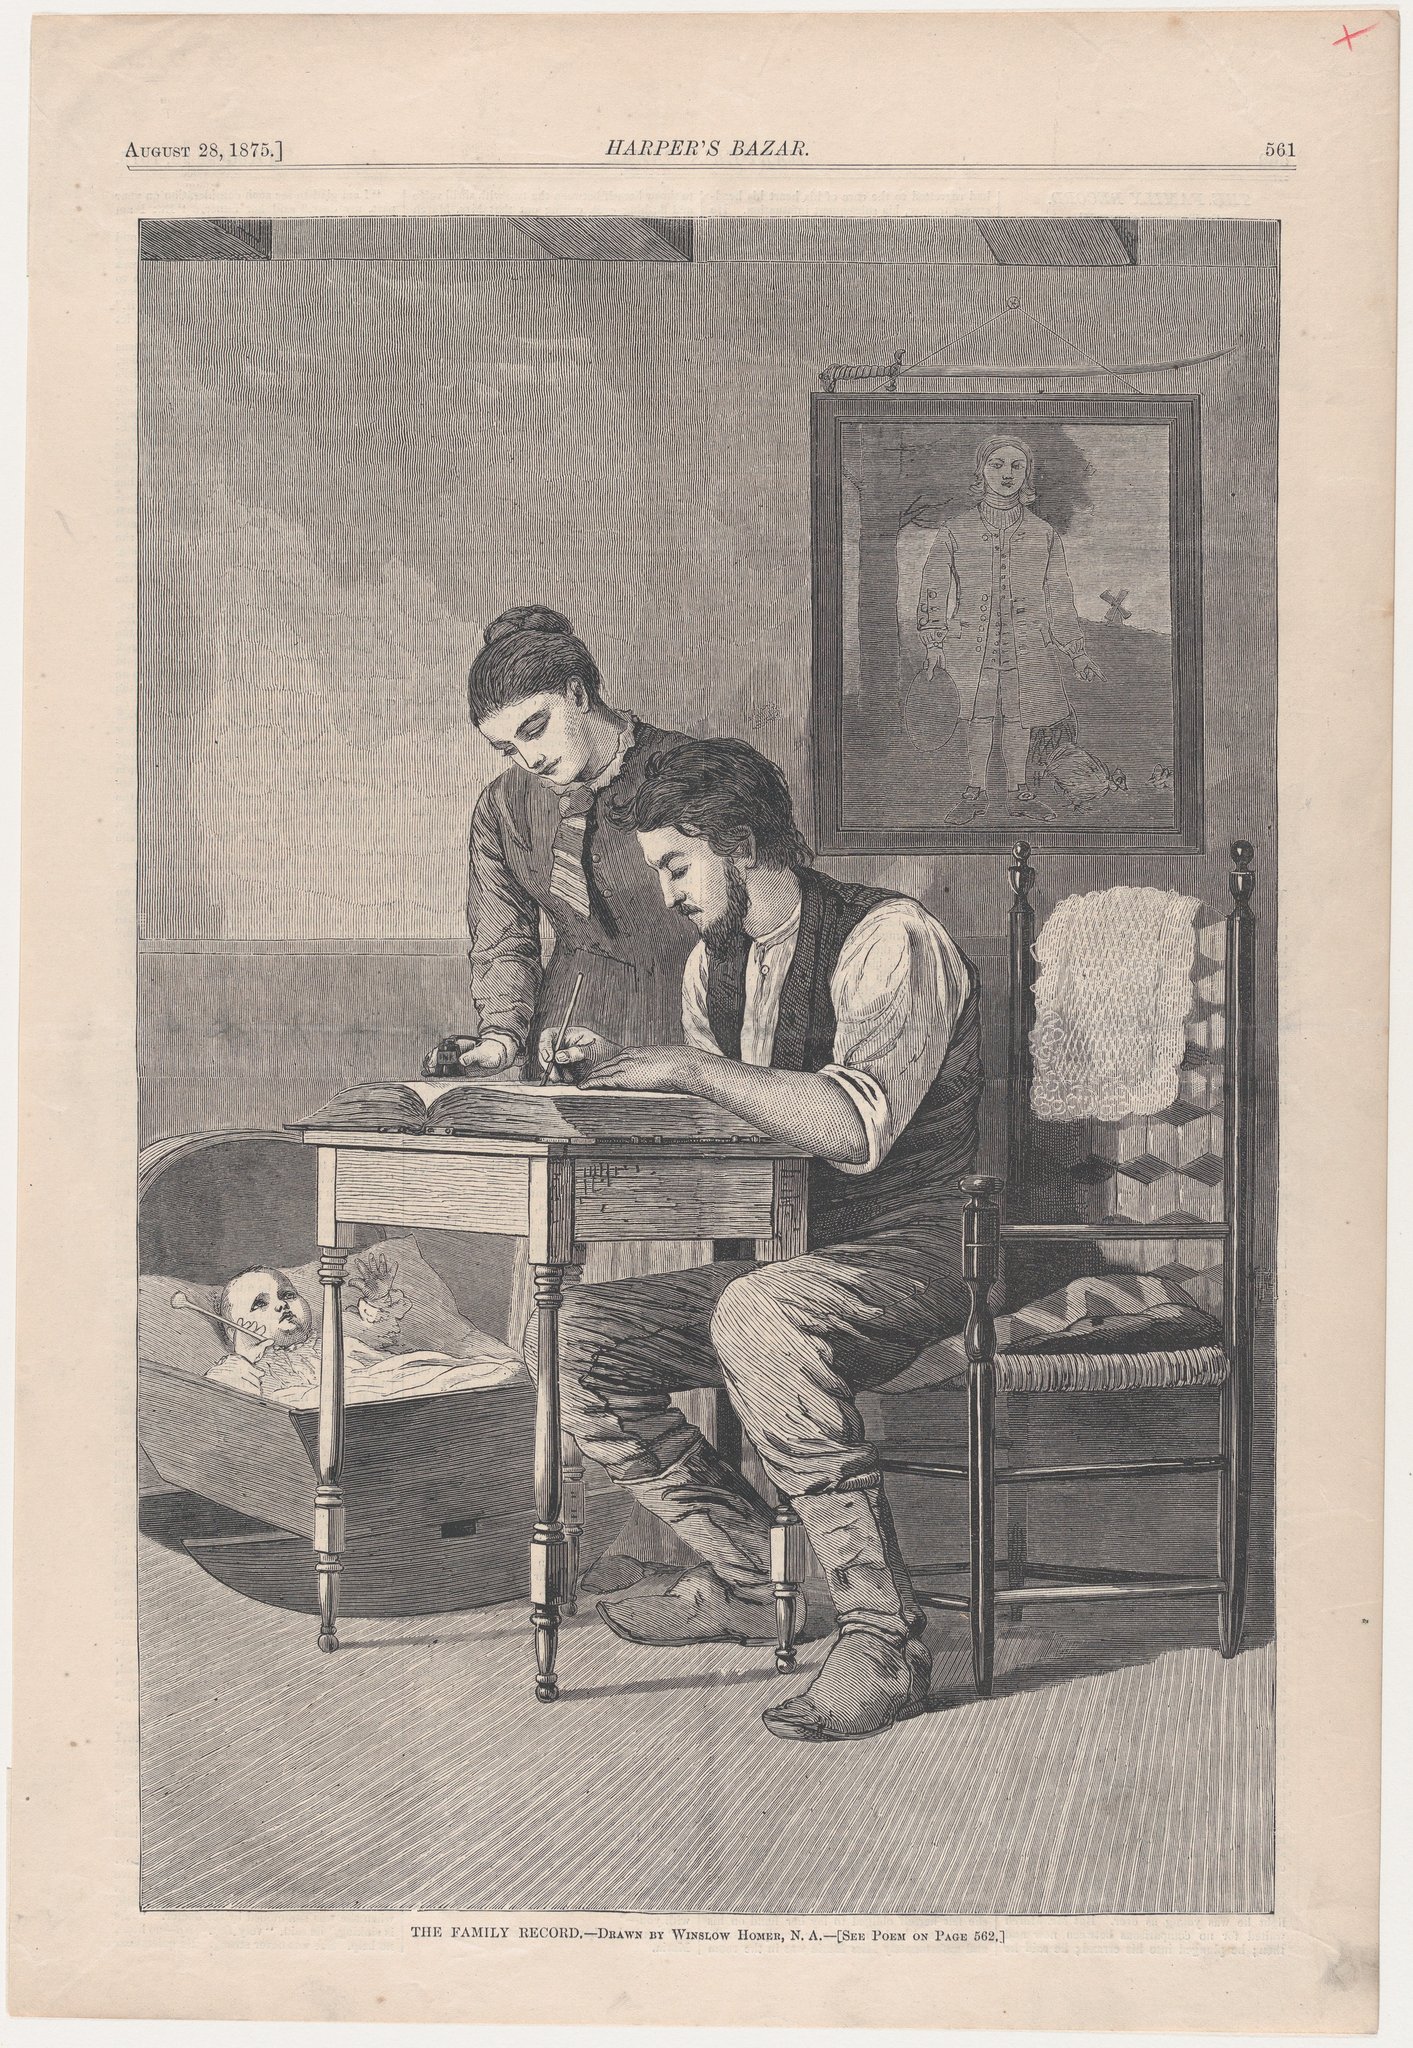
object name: print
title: The Family Record, from "Harper's Bazar," Vol. VIII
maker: winslow homer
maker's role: artist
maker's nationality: american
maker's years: 1836-1910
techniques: engraving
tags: infants,men,women,writing,family